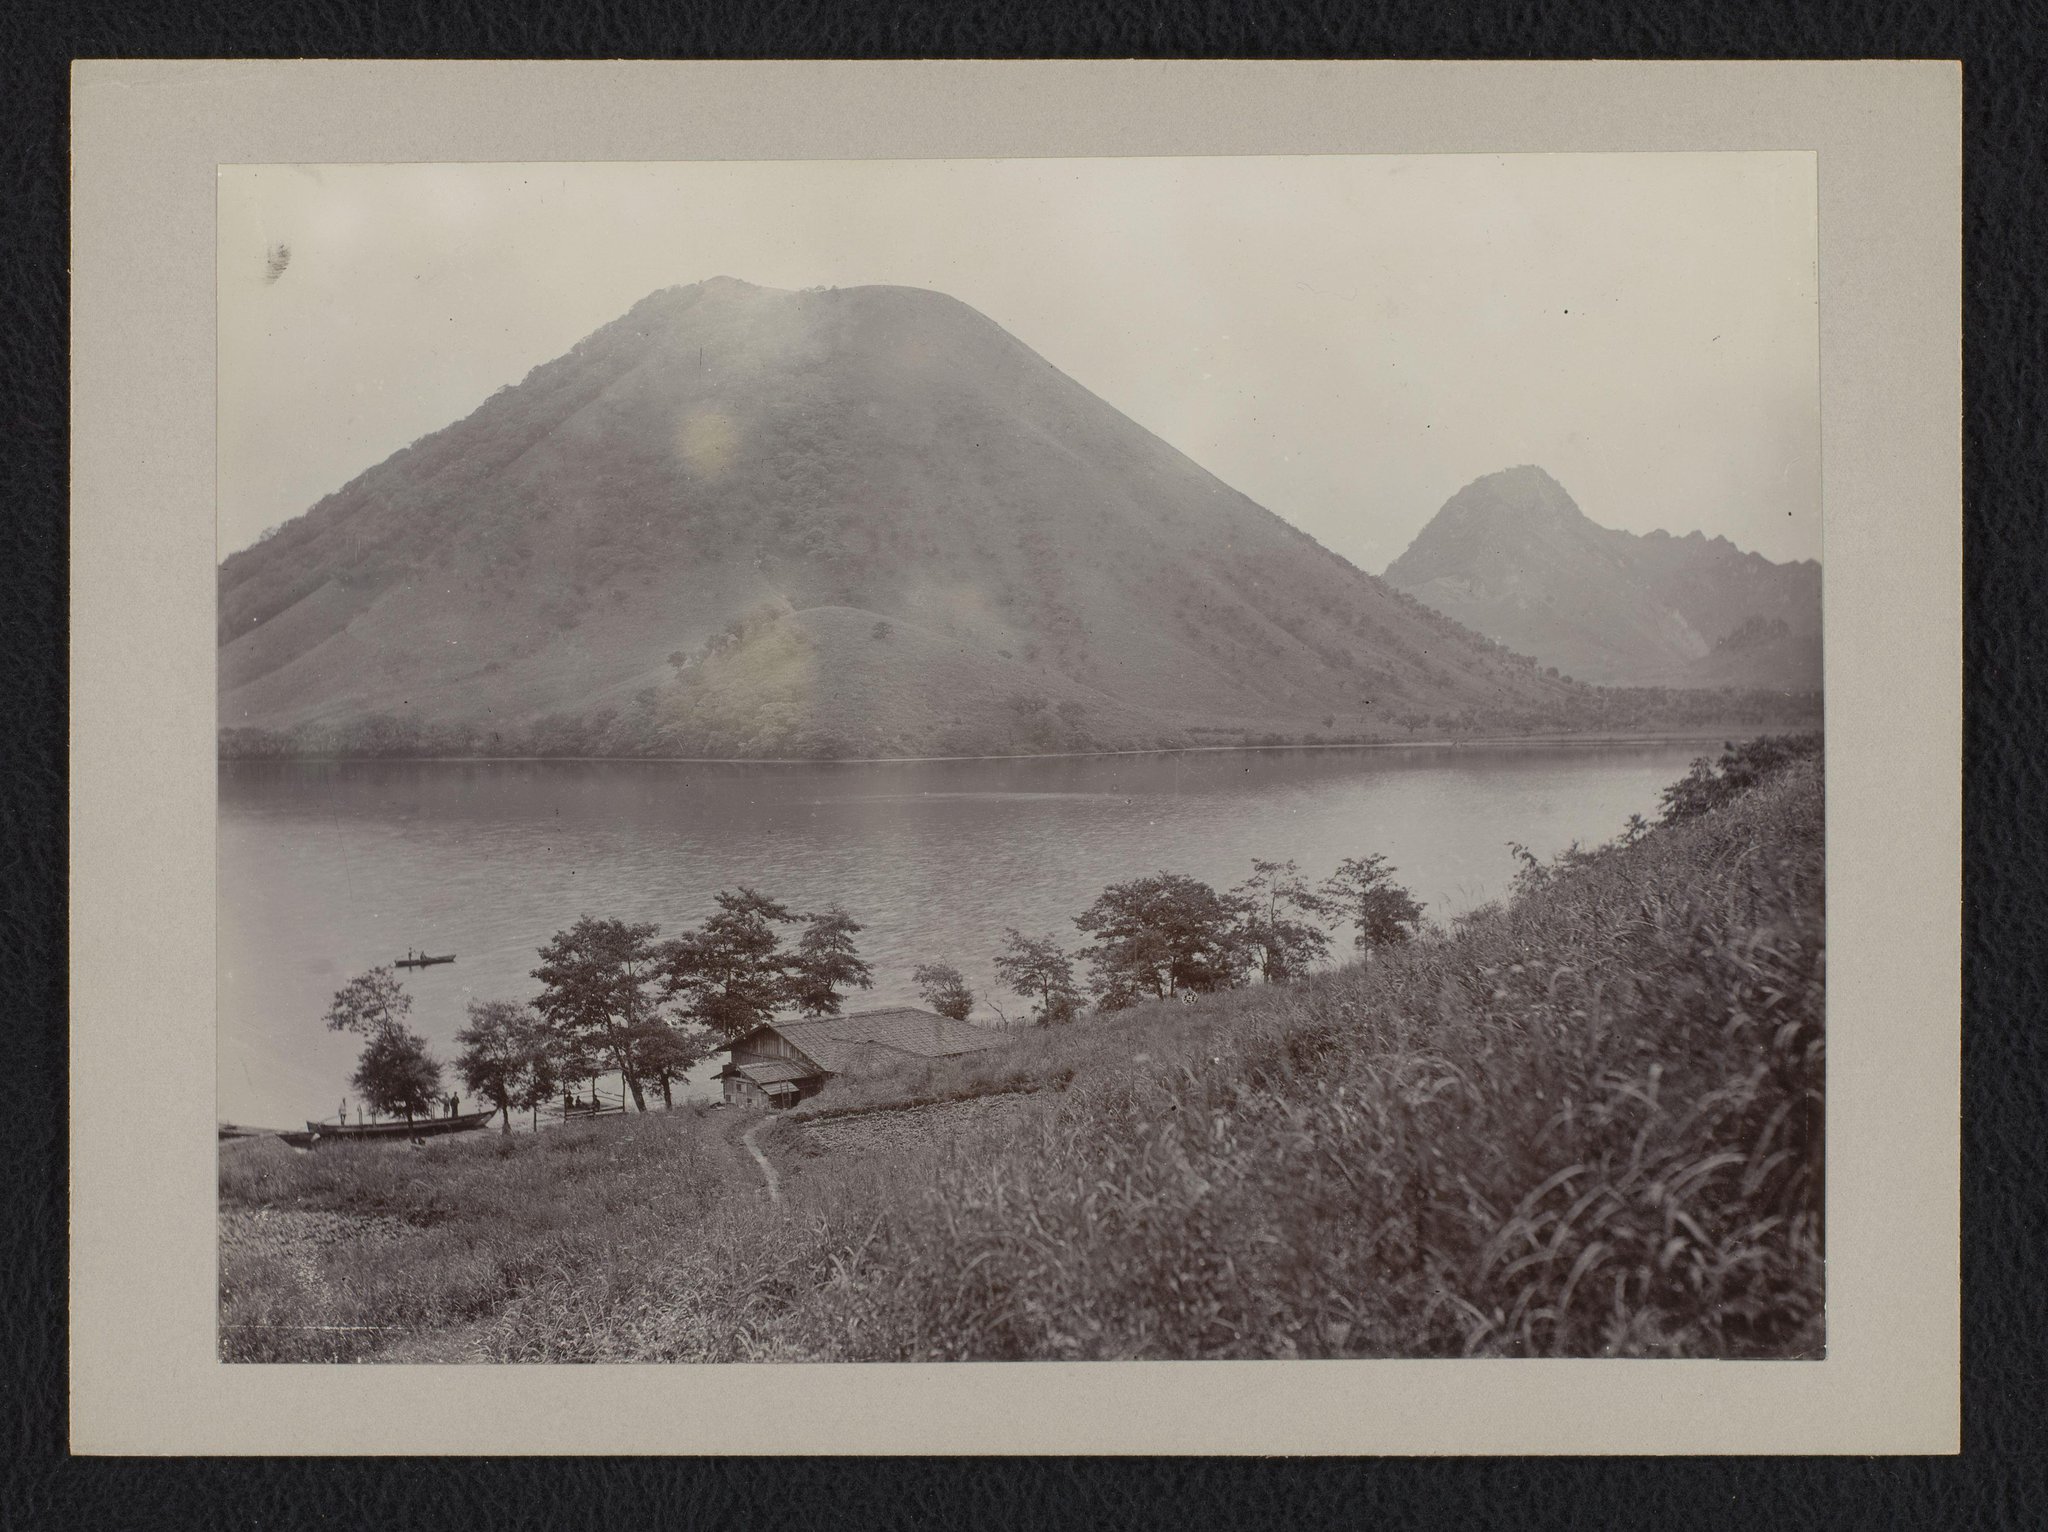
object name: photograph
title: Meer van Haruna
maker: Anonymous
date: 1895-1915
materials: cardboard, photographic support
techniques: collodion silver print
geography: haruna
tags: haruna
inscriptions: annotation: ‘44. Haruna lake.’